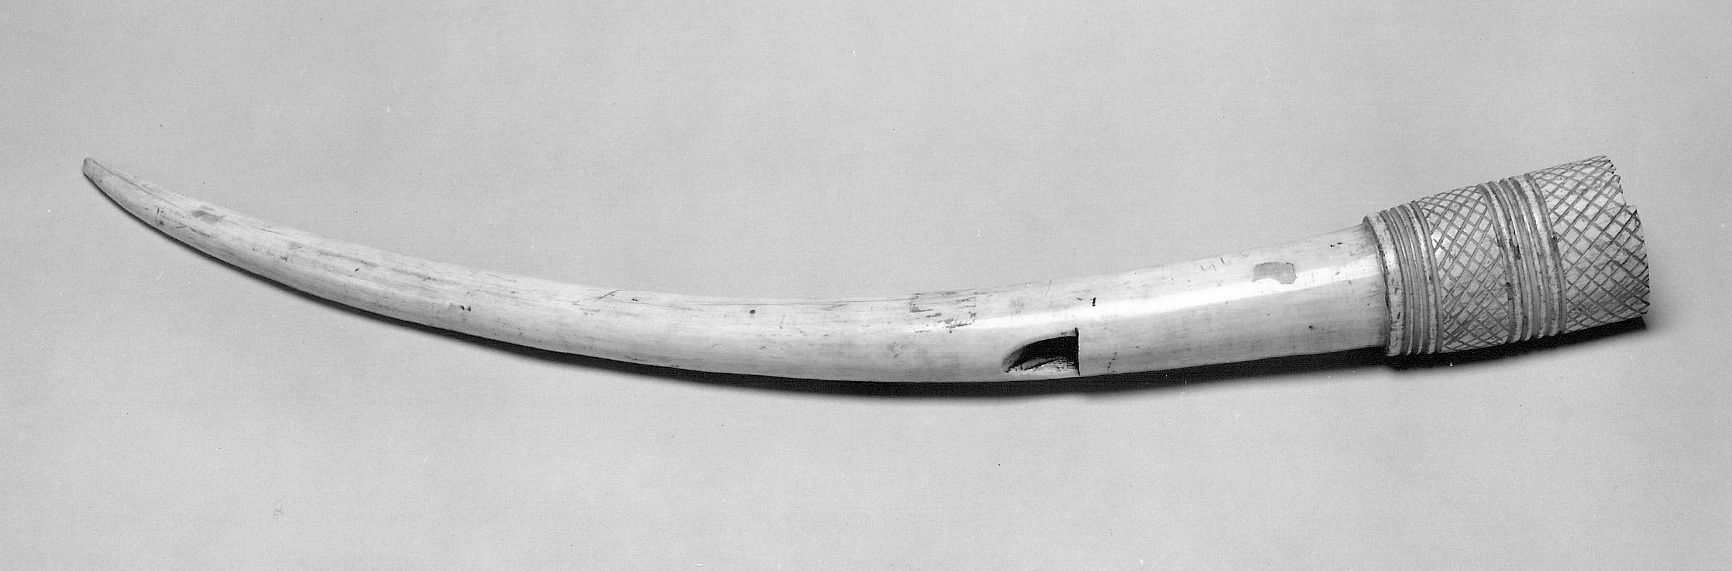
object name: horn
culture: igbo people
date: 1867-1900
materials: ivory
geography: nigeria